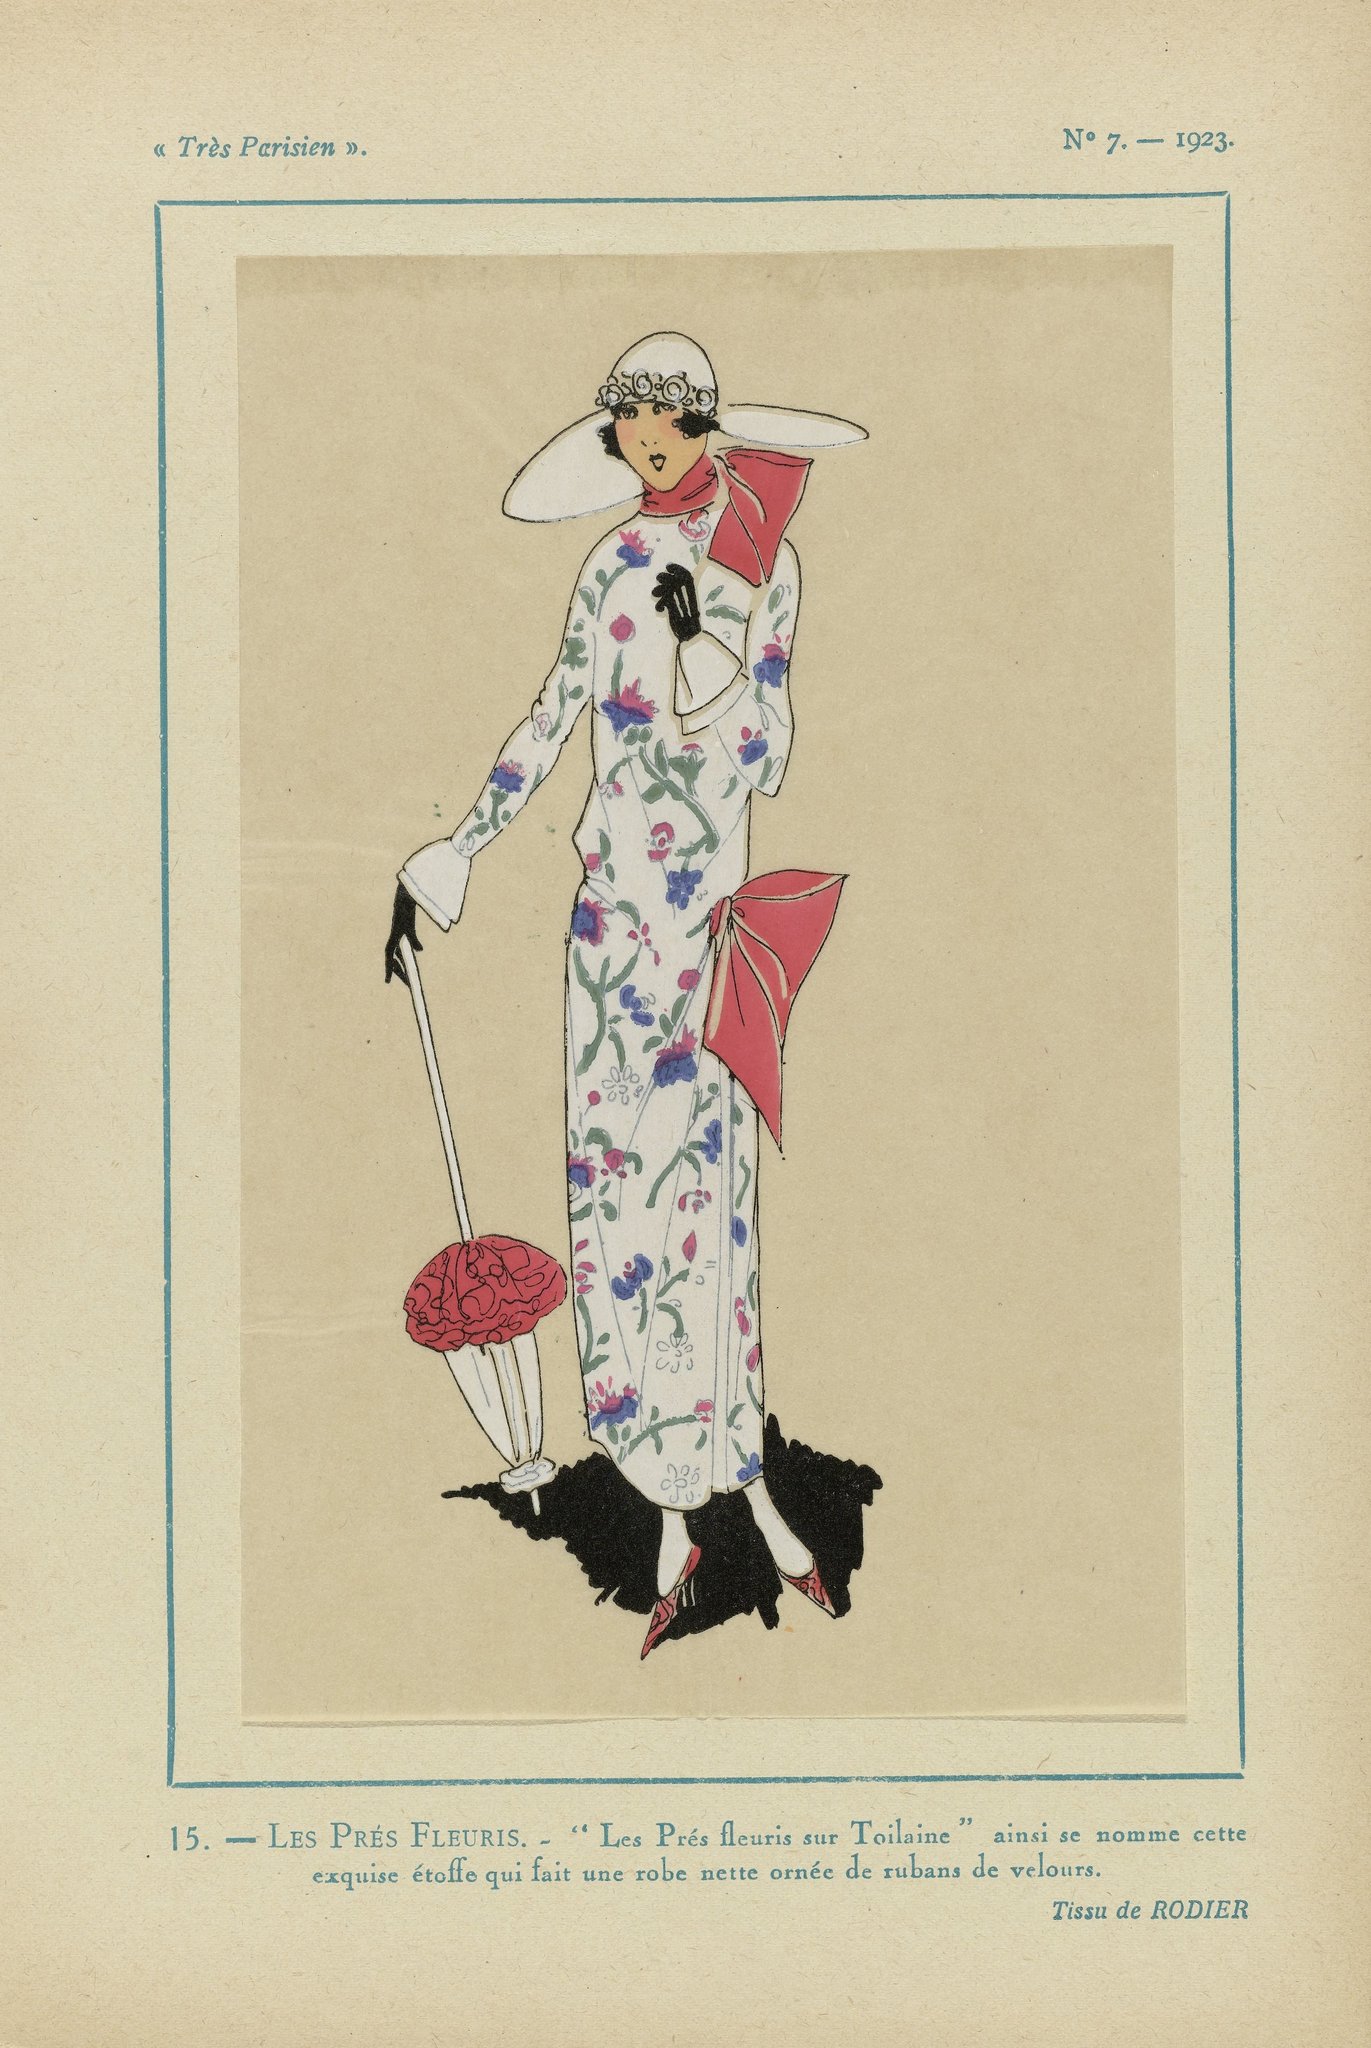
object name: fashion print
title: Très Parisien, 1923, No 7: 15.- LES PRÉS FLEURIS. - "Les Prés fleuris sur Toilaine"...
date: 1923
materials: paper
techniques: hand coloring, letterpress printing, lithography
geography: paris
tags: embroidery (ornamentation) (+ women's clothes), fashion plates, head-gear: hat (+ women's clothes), dress, gown (+ women's clothes), parasol, sunshade (+ women's clothes)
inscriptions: caption: ‘15. - LES PRÉS FLEURIS. - "Les Prés fleuris sur Toilaine" ainsi se nomme cette exquise étoffe qui fait une robe nette ornée de rubans de velours. / Tissu de RODIER.’, title: ‘Très Parisien / No 7. - 1923’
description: Jurk van "Les Prés fleuris sur Toilaine"; een stof met bloemmotief versierd met linten van fluweel. Stof van Rodier. Accessoires: Hoed met brede rand versierd met bloemen, handschoenen, wandelstok (parasol), pumps. Prent uit het modetijdschrift Très Parisien (1920-1936).